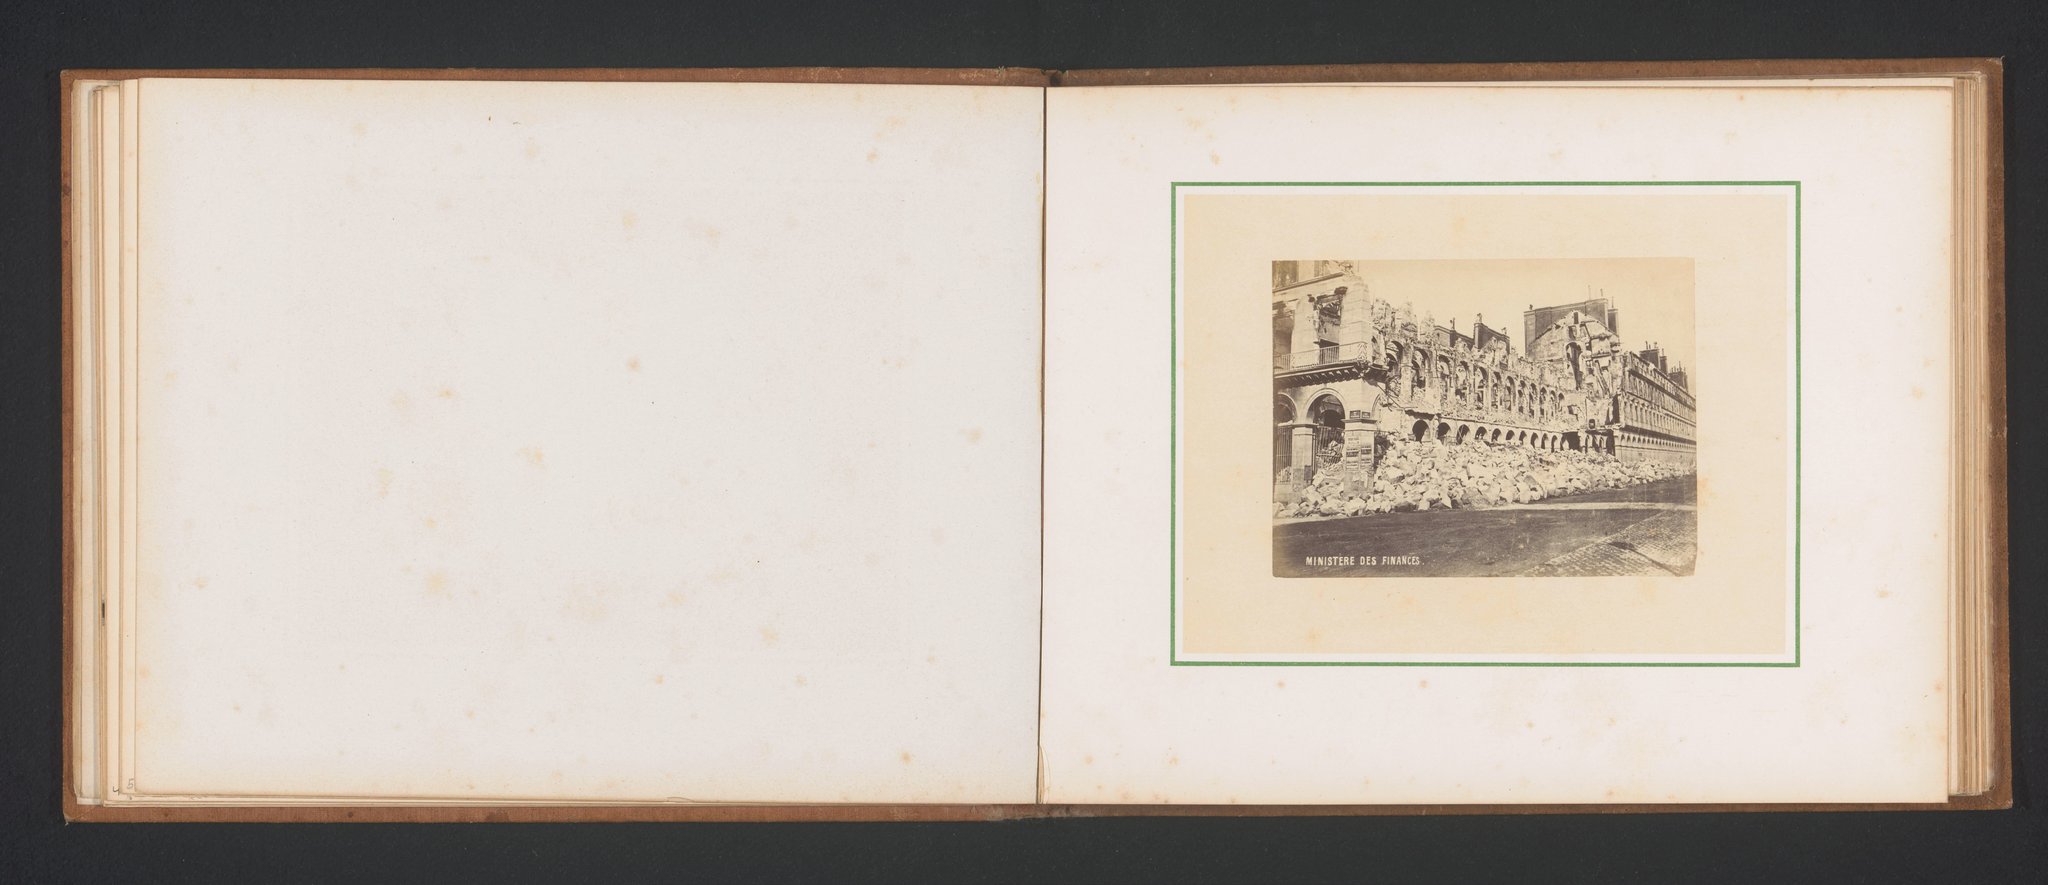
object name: page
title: Gezicht op het Ministerie van Financiën in Parijs na de brand door de Commune van Parijs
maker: p. loubère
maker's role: fotograaf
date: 1871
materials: photographic support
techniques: albumen print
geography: paris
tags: ruin of a building ~ architecture, organization of trade and finance, national government, paris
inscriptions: monogram: ‘P.L.’